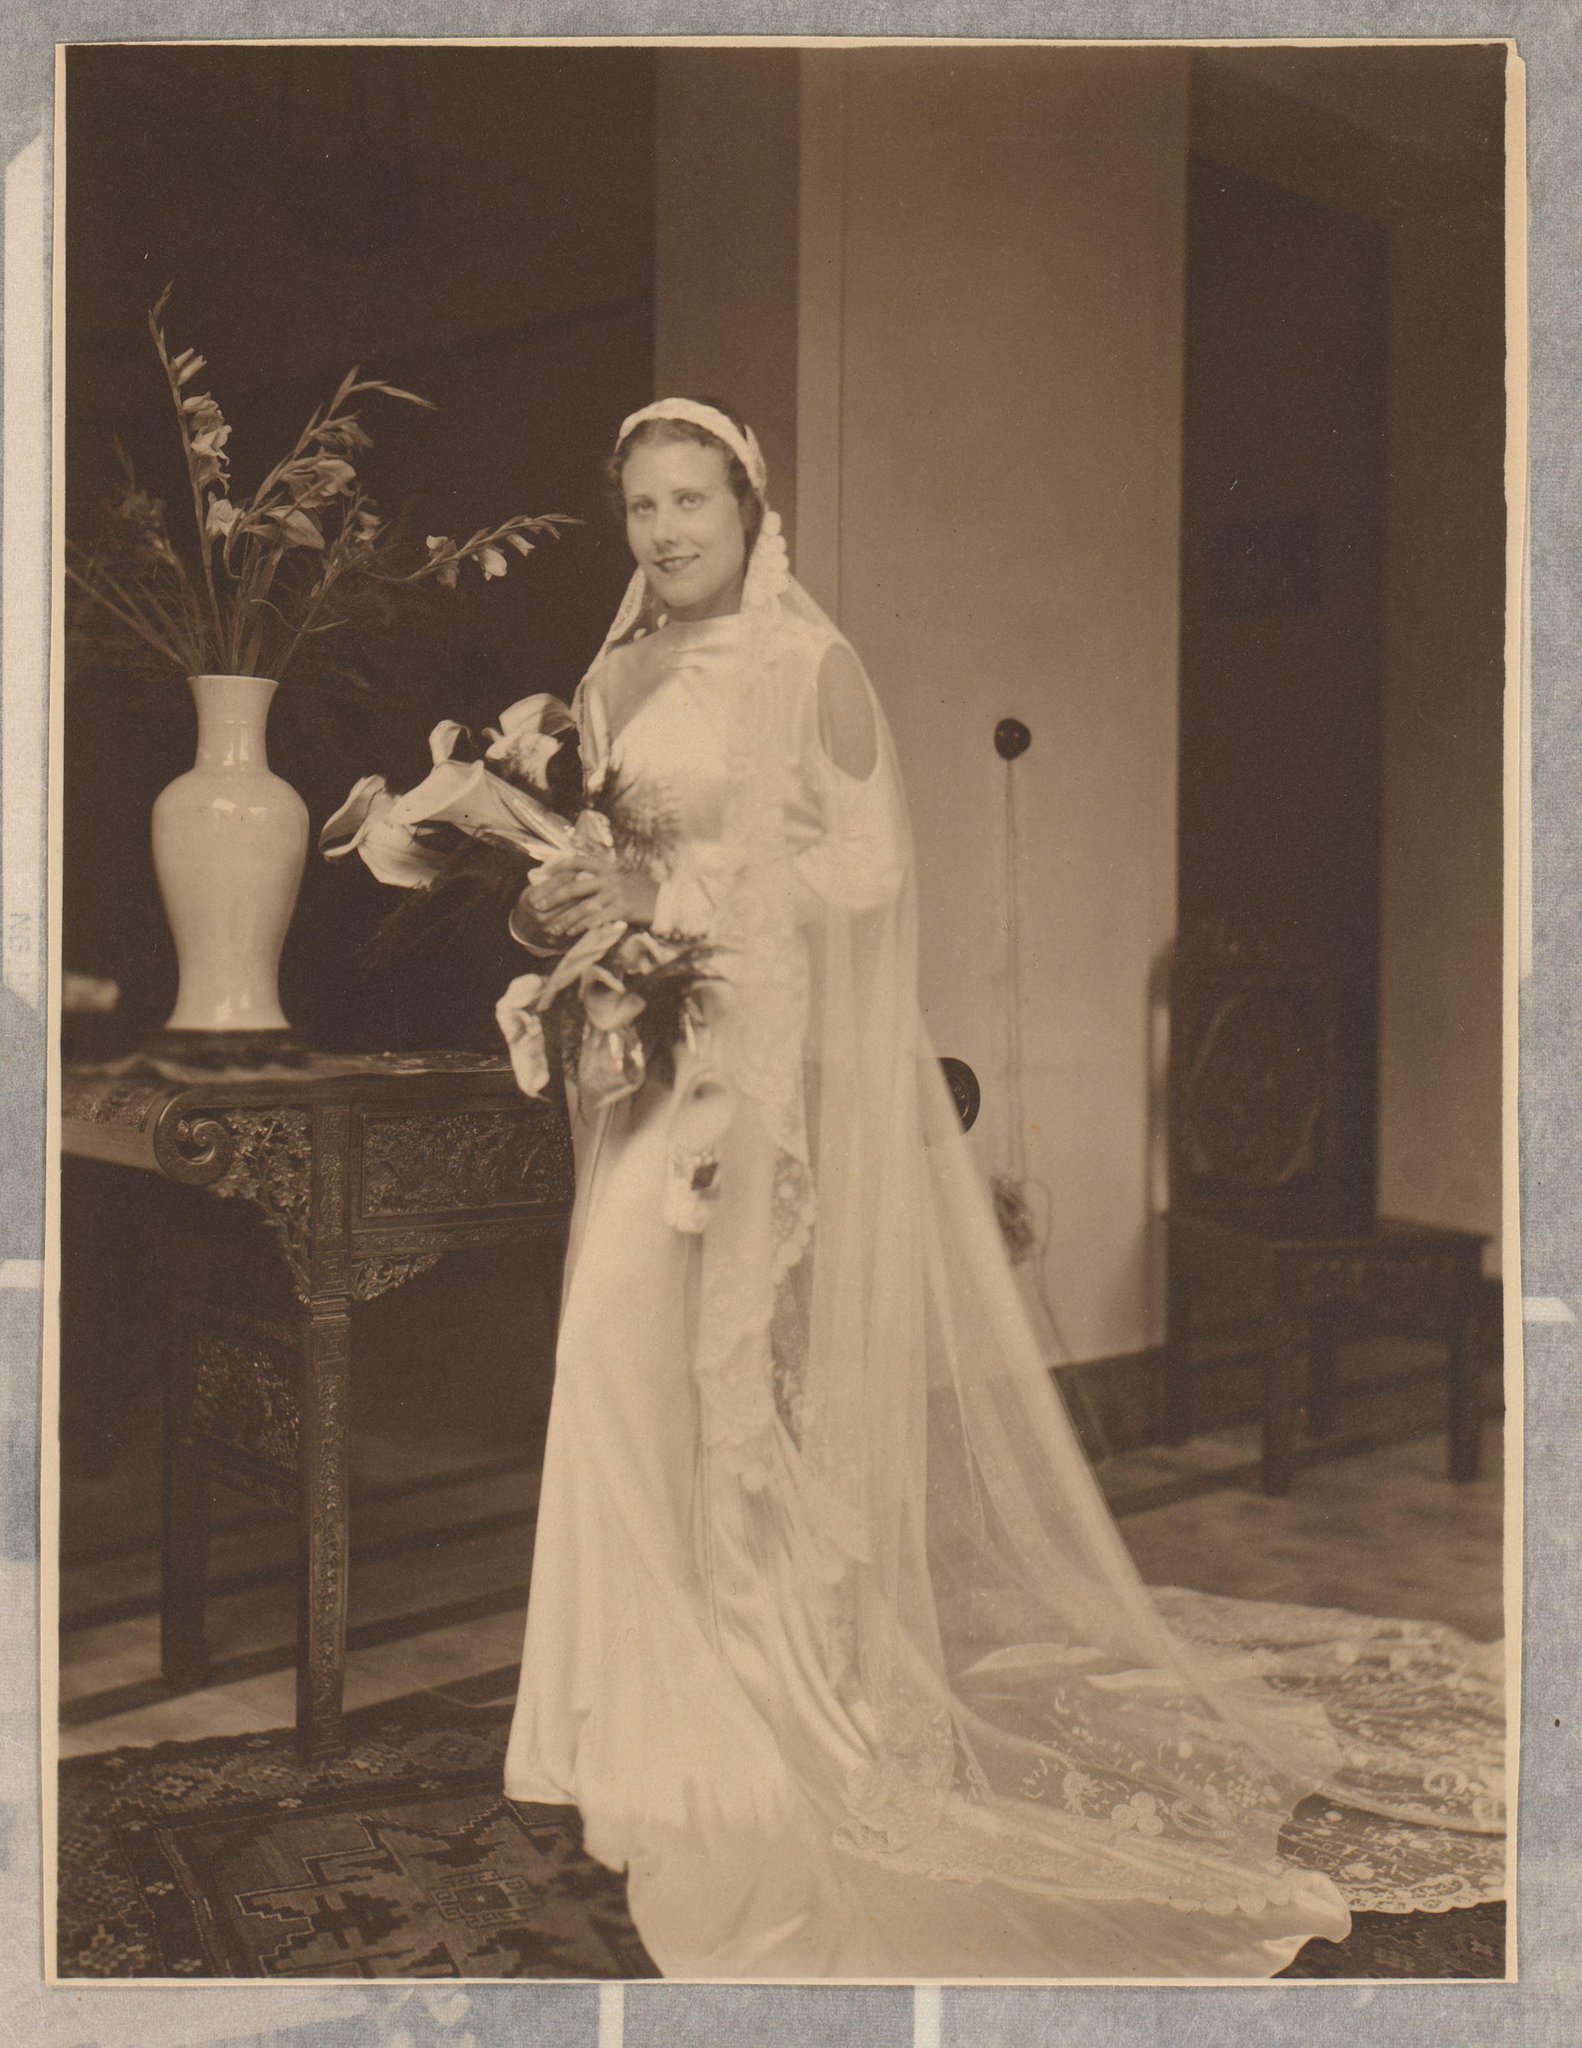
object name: photograph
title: Portret van een bruid op een bruiloft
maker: Anonymous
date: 1934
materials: paper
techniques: gelatin silver print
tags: historical persons not known by name - bb - woman, bride (in wedding-dress)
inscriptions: inscription: ‘[...] standaard/ René - hertg[...]/ de Jong/ 21e/163’